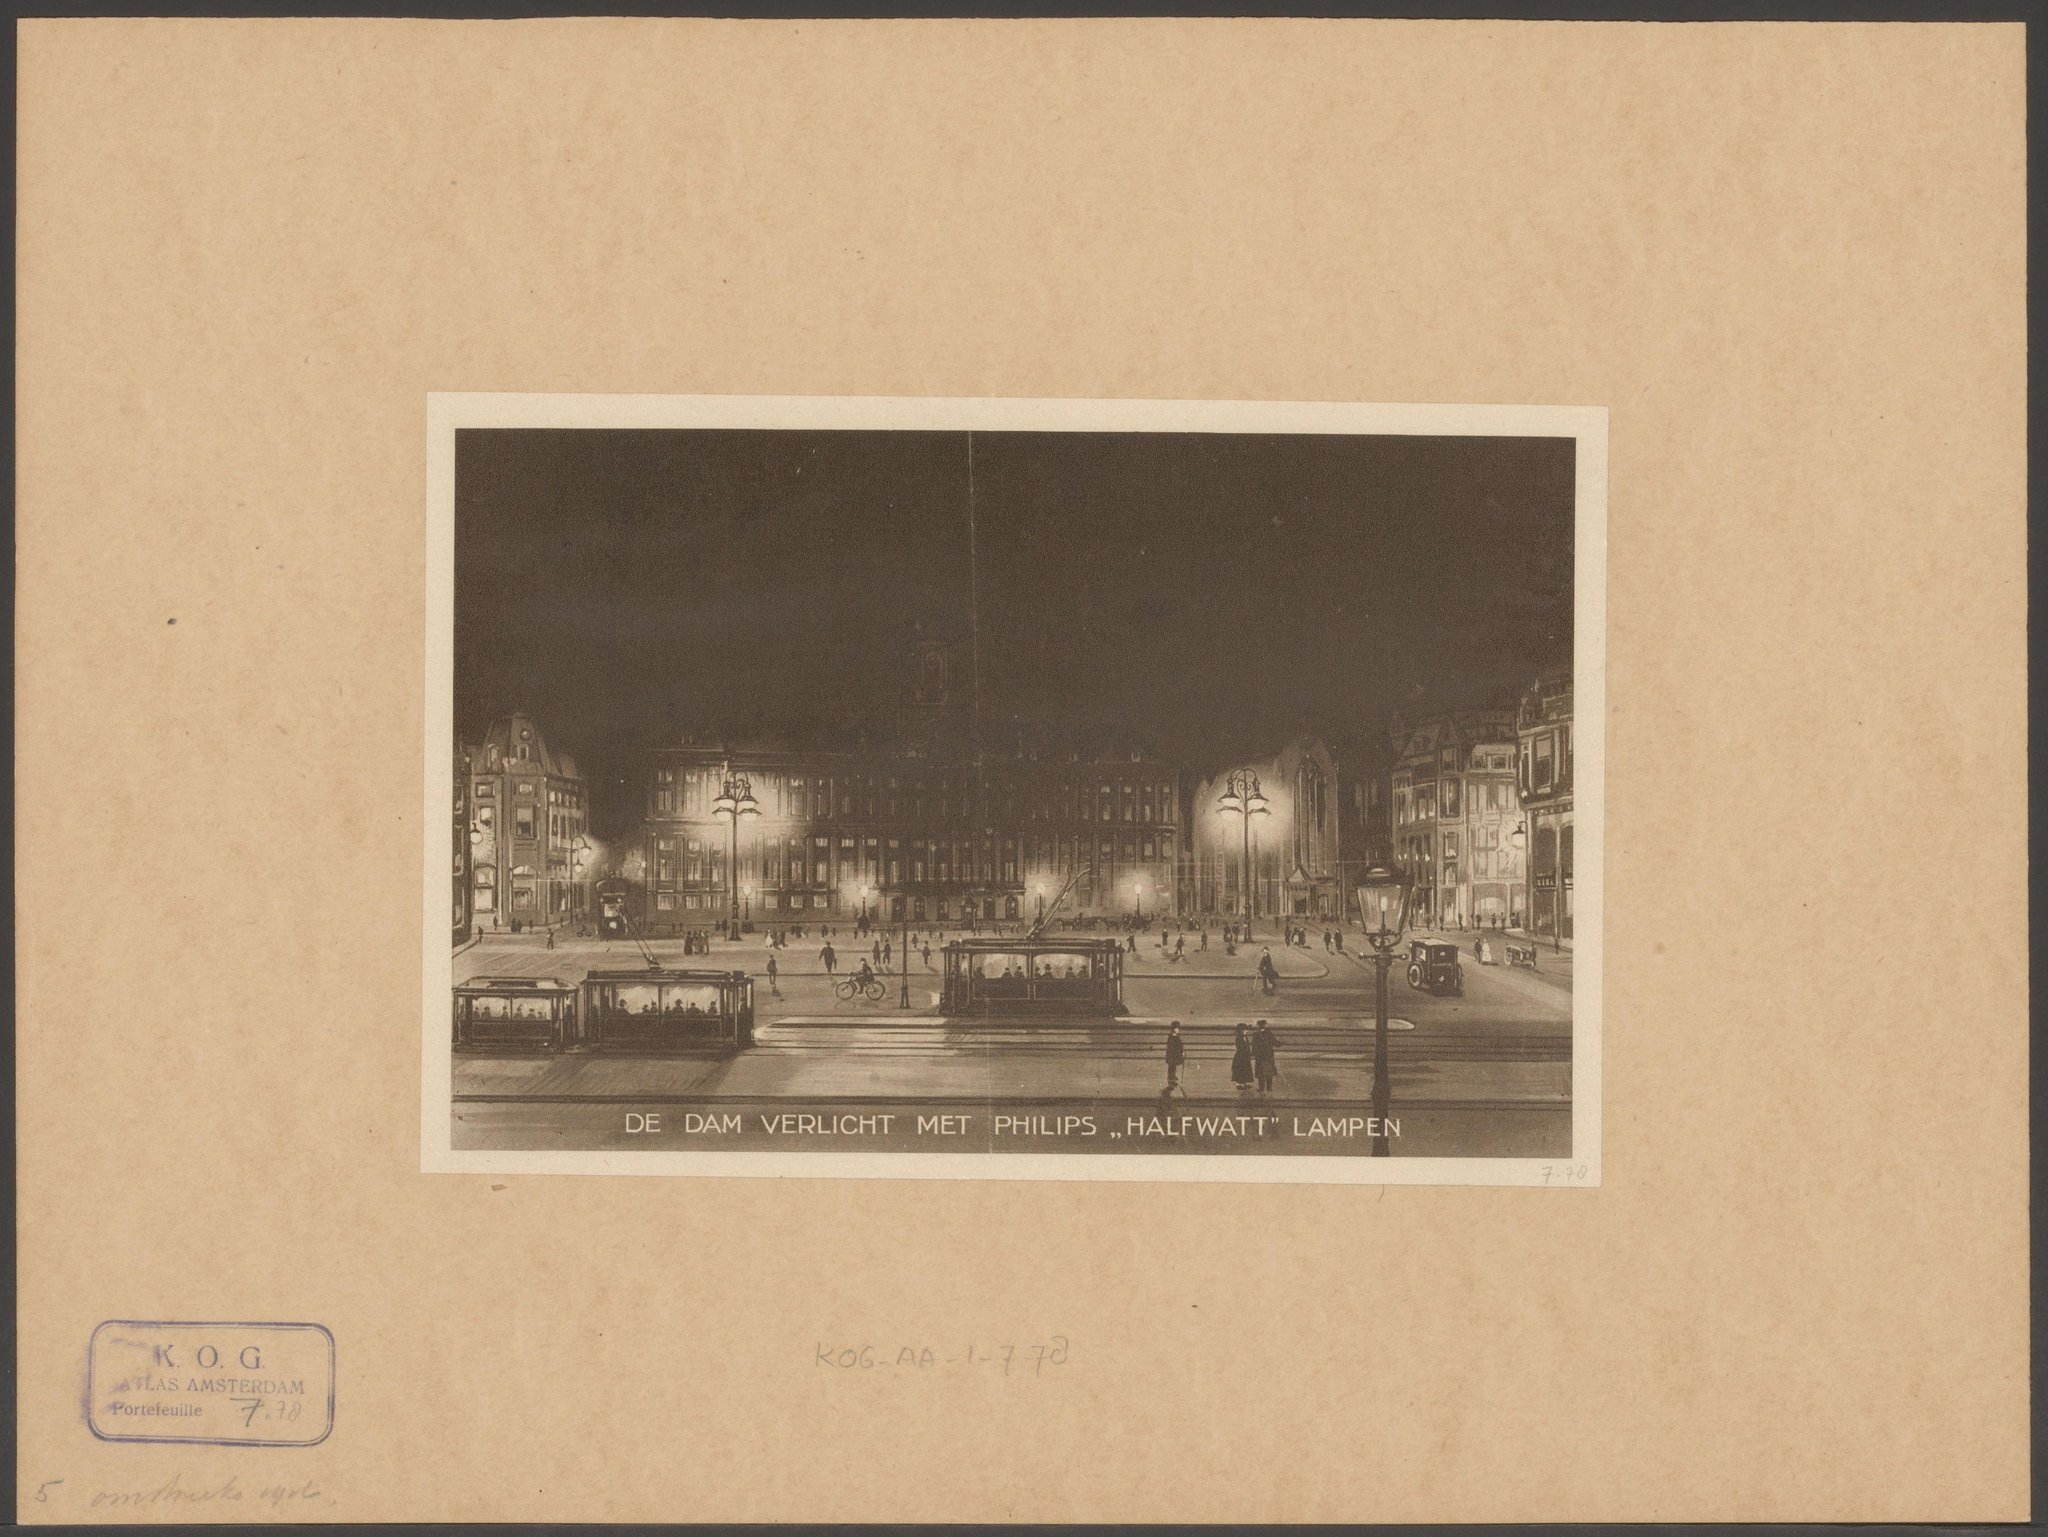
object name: photomechanical print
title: Gezicht op de Dam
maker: Anonymous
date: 1910-1920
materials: paper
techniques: rotogravure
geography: amsterdam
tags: square, place, circus, etc., city-view in general; 'veduta', artificial light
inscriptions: collector's mark: ‘7’ Lugt 1641b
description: Onderwerpsrubriek binnen de Atlas Amsterdam: Dam (na 1835).